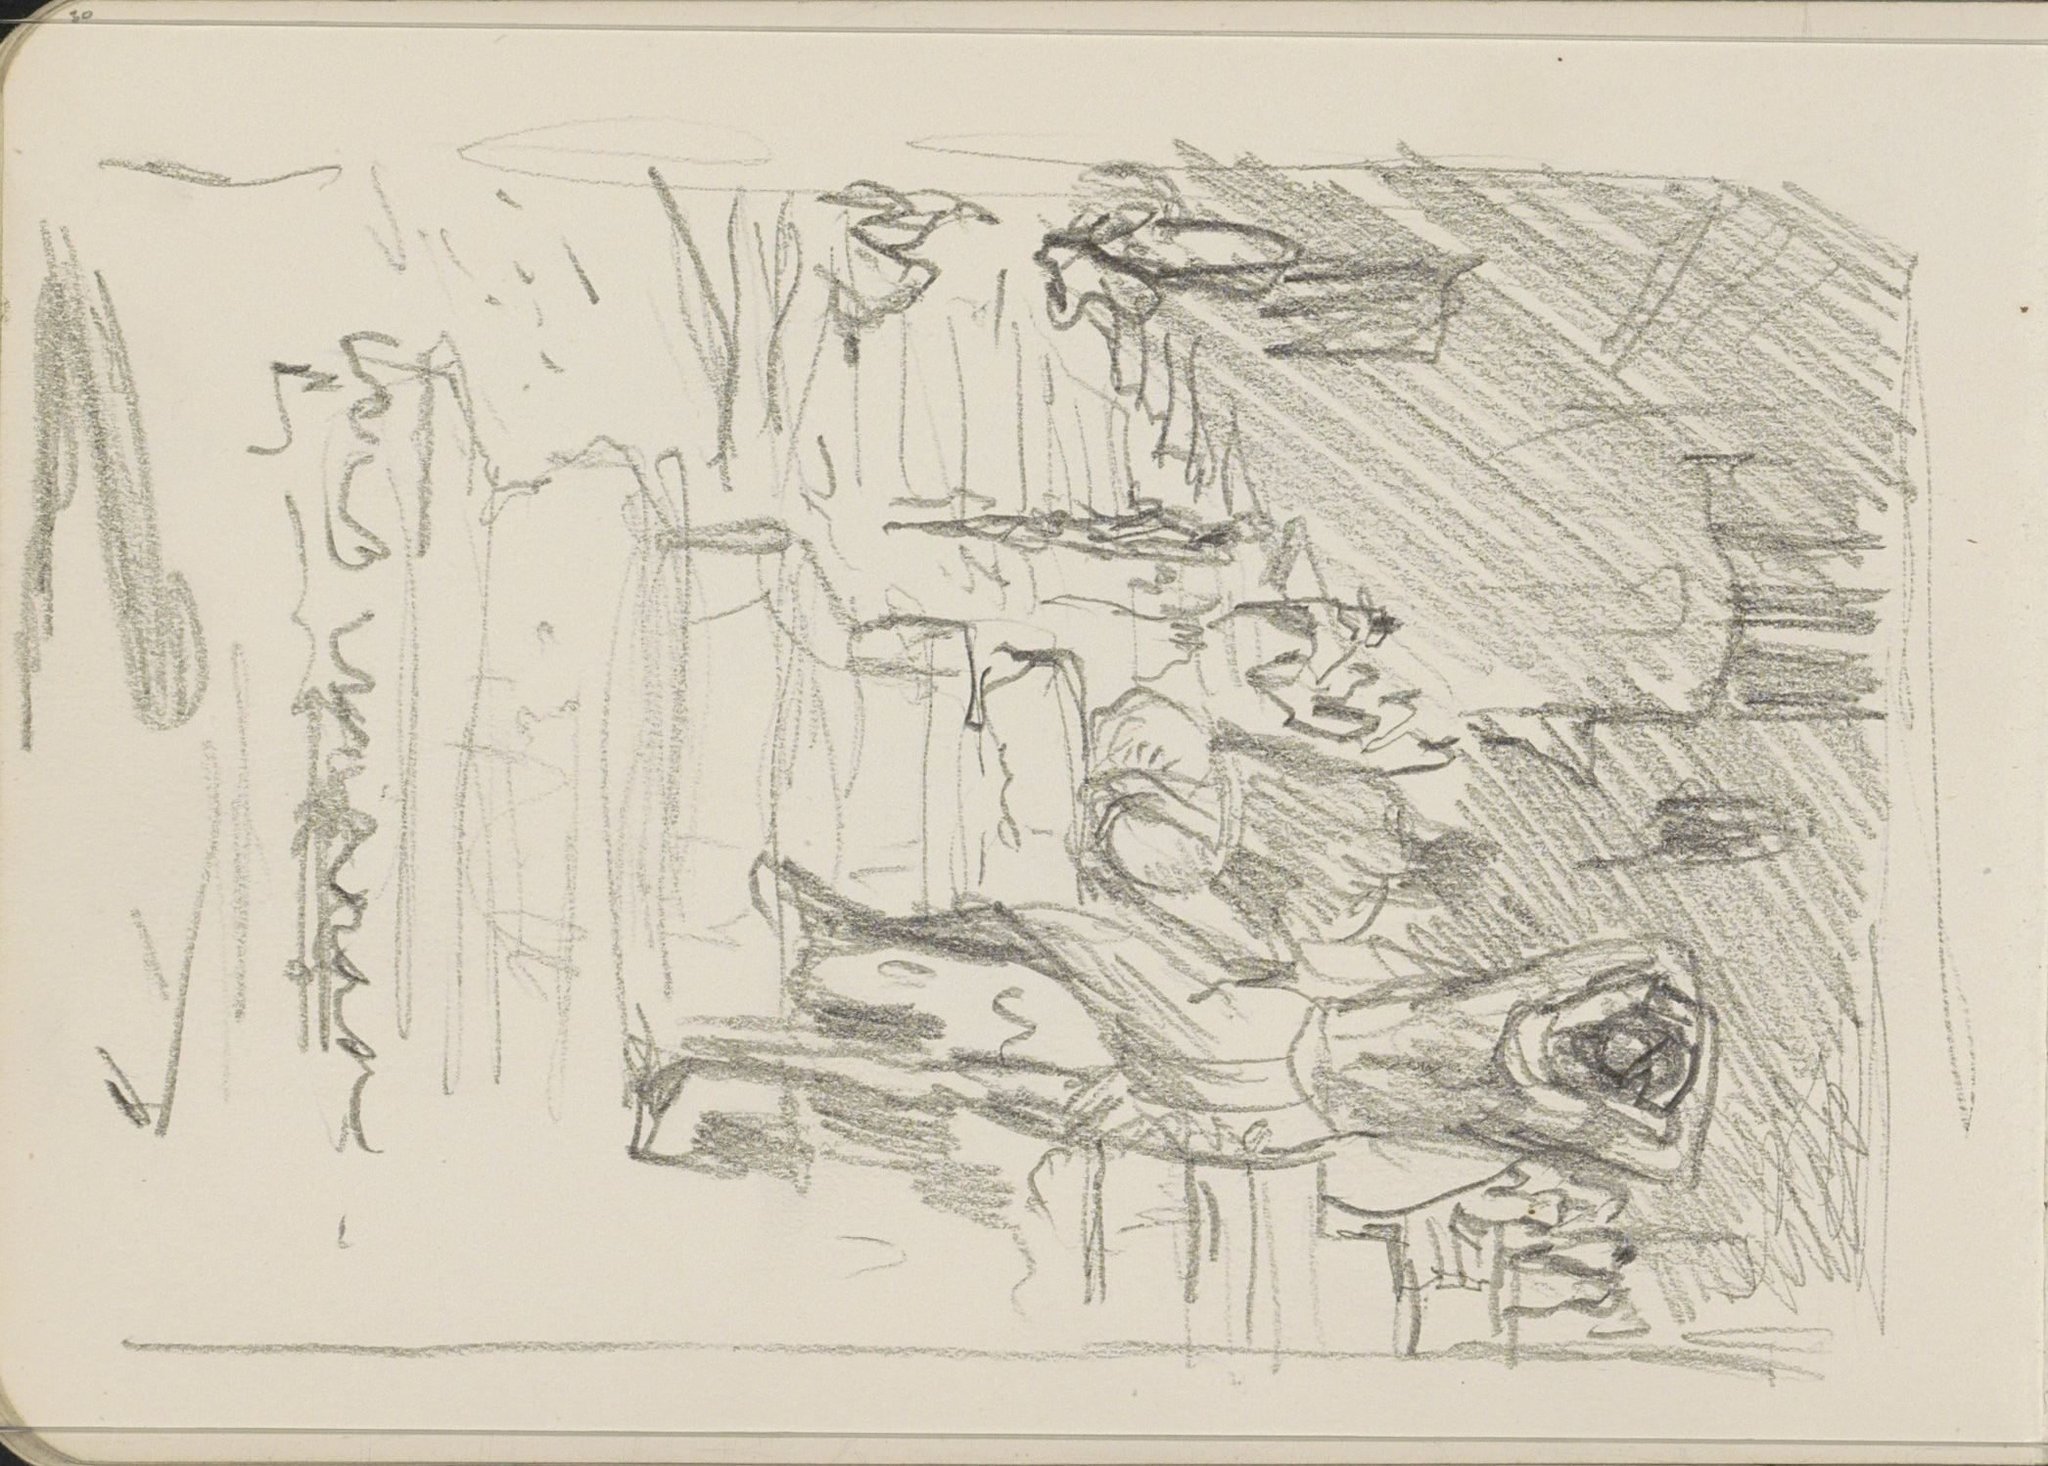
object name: sketchbook leaf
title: Indiërs op een trap aan de Ganges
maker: marius bauer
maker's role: draughtsman, print maker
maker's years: 1867-1932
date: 1924-1925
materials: paper, pencil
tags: standing figure, sitting figure, flight of steps, asiatic races and peoples: indians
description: De figuren staan en zitten op de trap die naar de rivier leidt. Pagina 30 uit een schetsboek met 23 bladen.